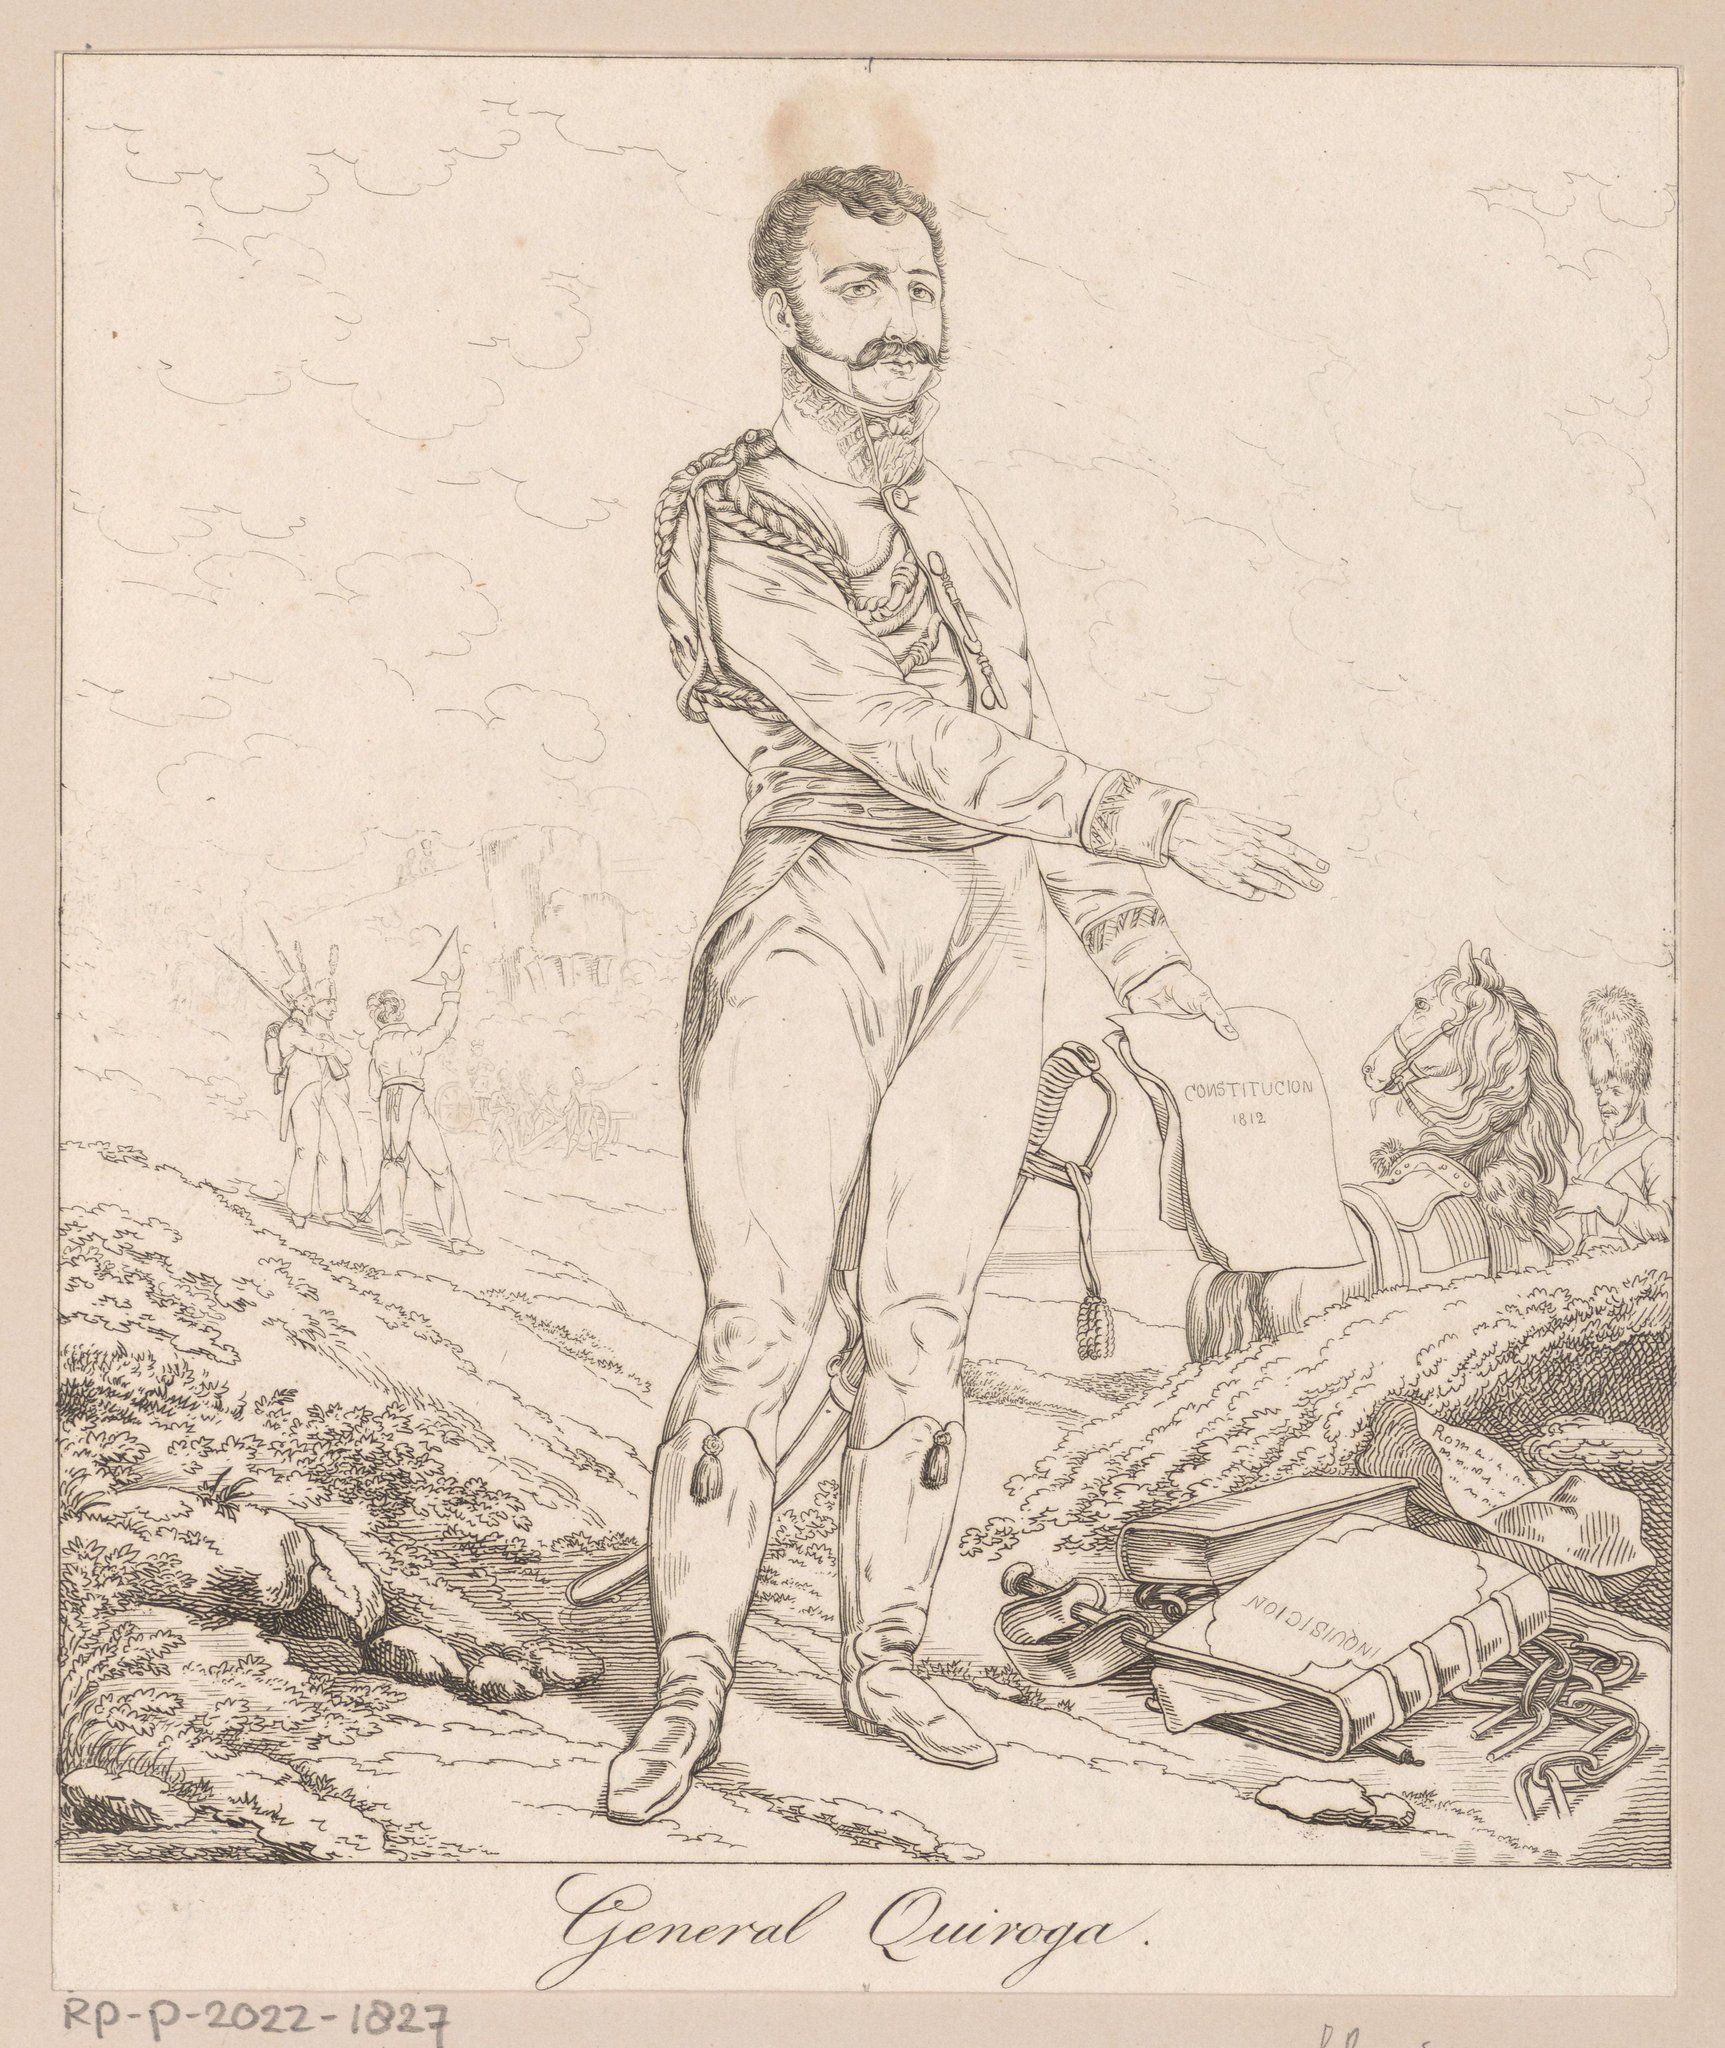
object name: print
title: Portret van Antonio Quiroga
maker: Anonymous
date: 1812-1875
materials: paper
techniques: etching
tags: commander-in-chief, general, marshal, historical persons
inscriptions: inscription: ‘Kapitein Generaal in Grenada / + San Jago 25 maart 1841’